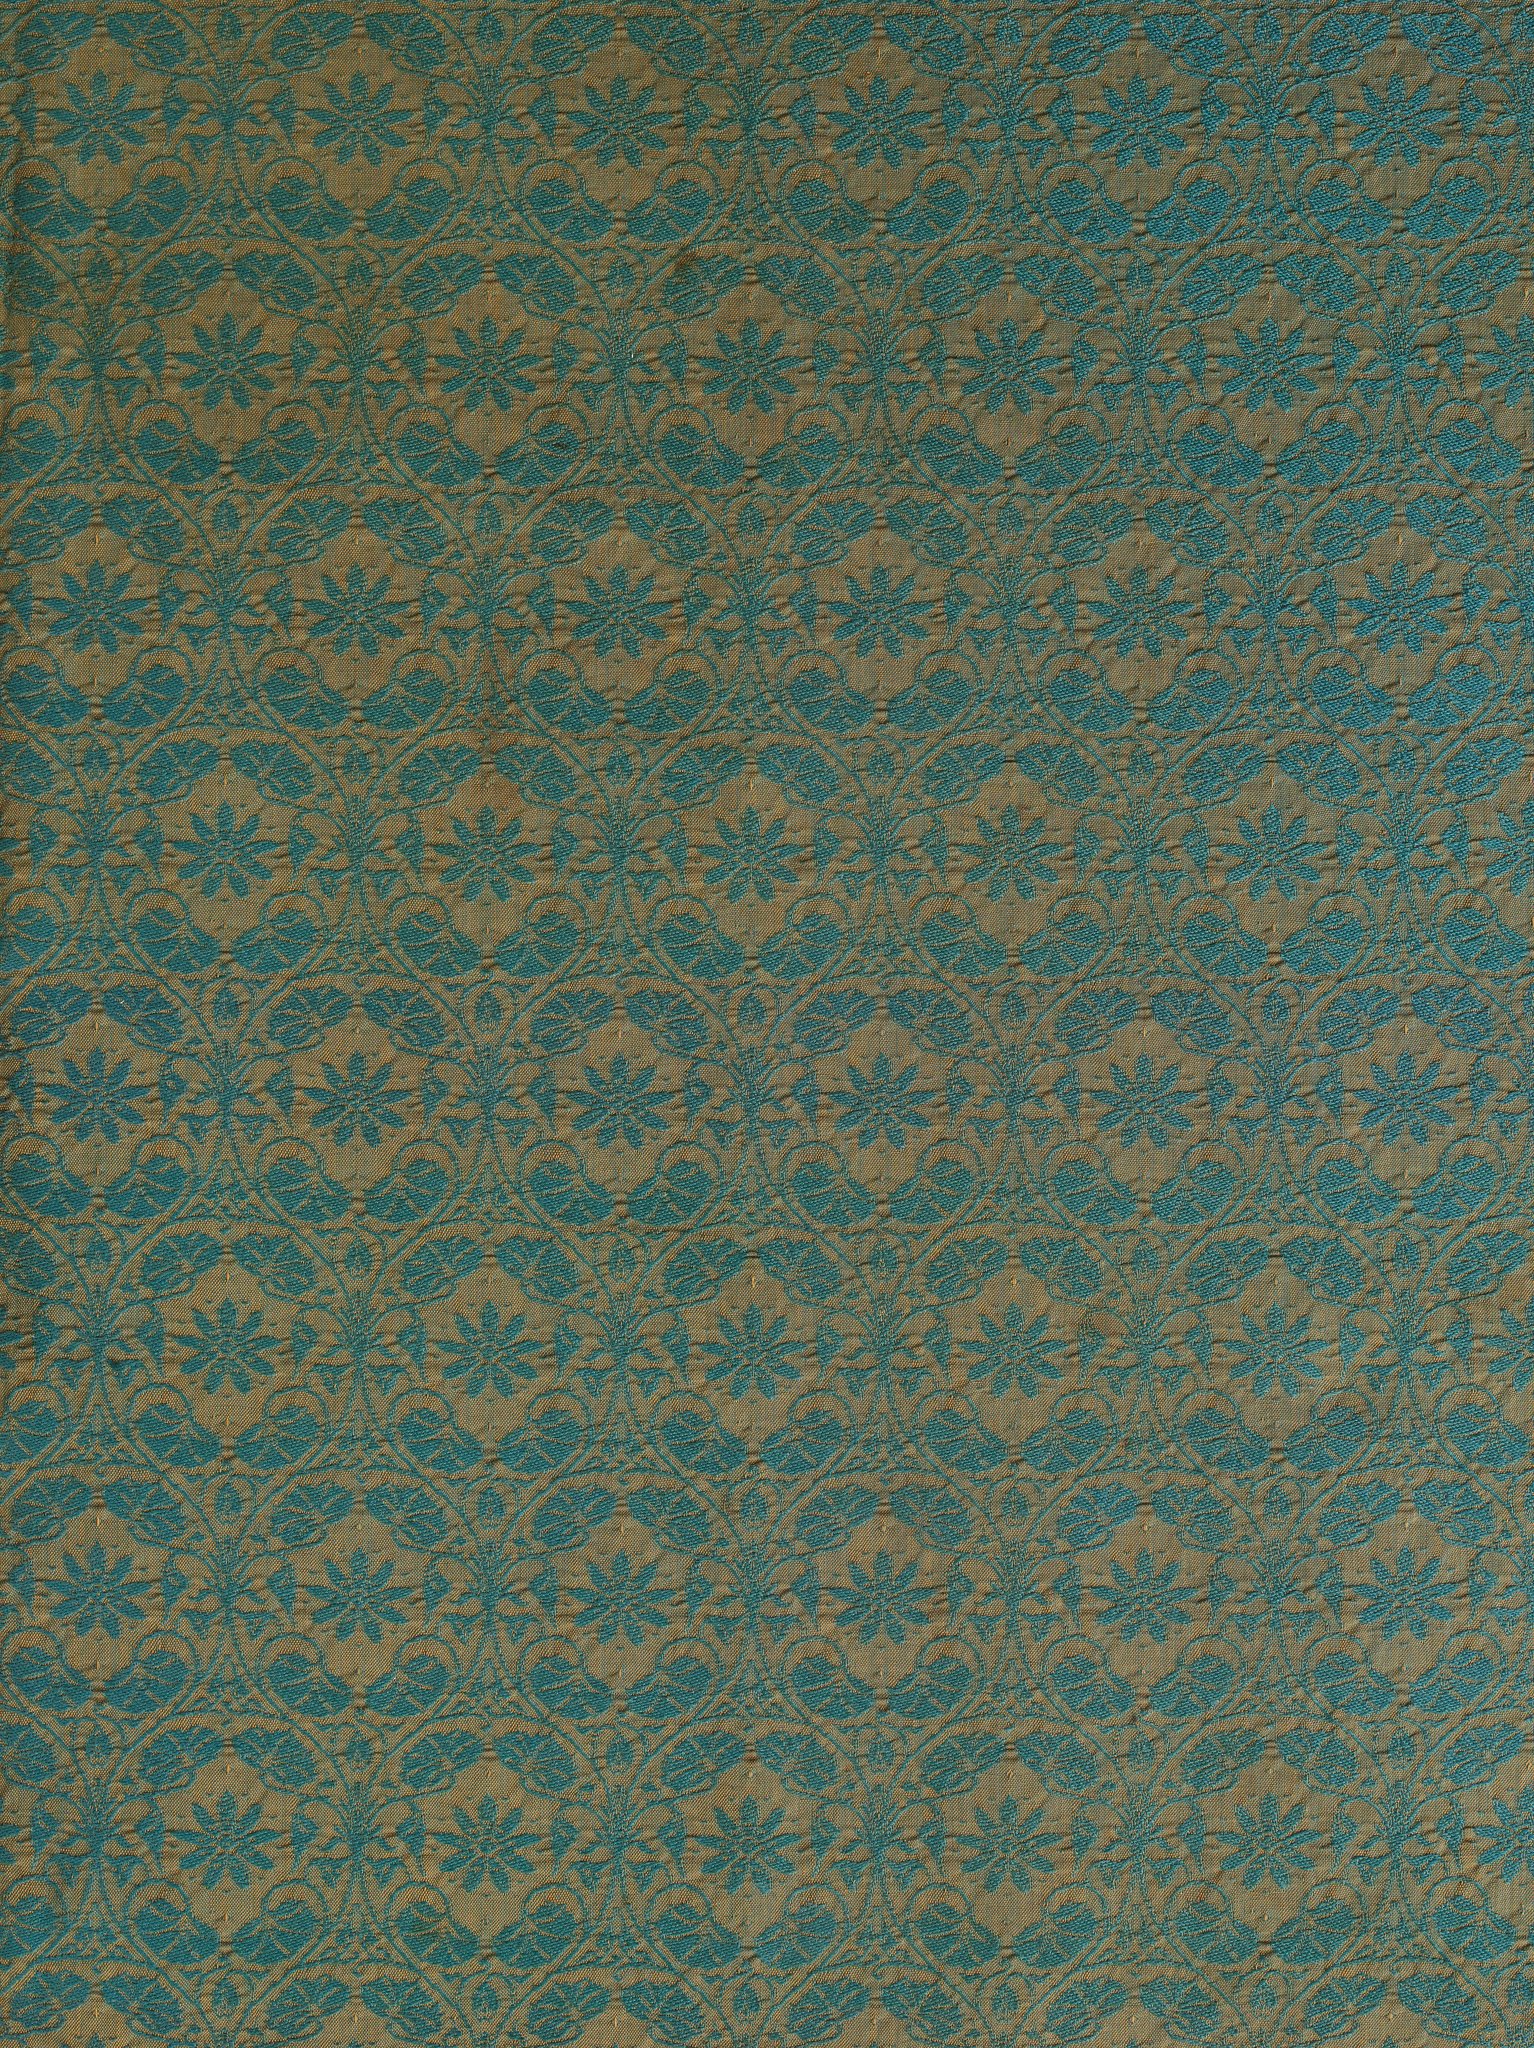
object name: curtain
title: Gordijn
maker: theo nieuwenhuis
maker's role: designer, draughtsman, print maker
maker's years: 1866-1951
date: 1880-1949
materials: cotton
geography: helmond